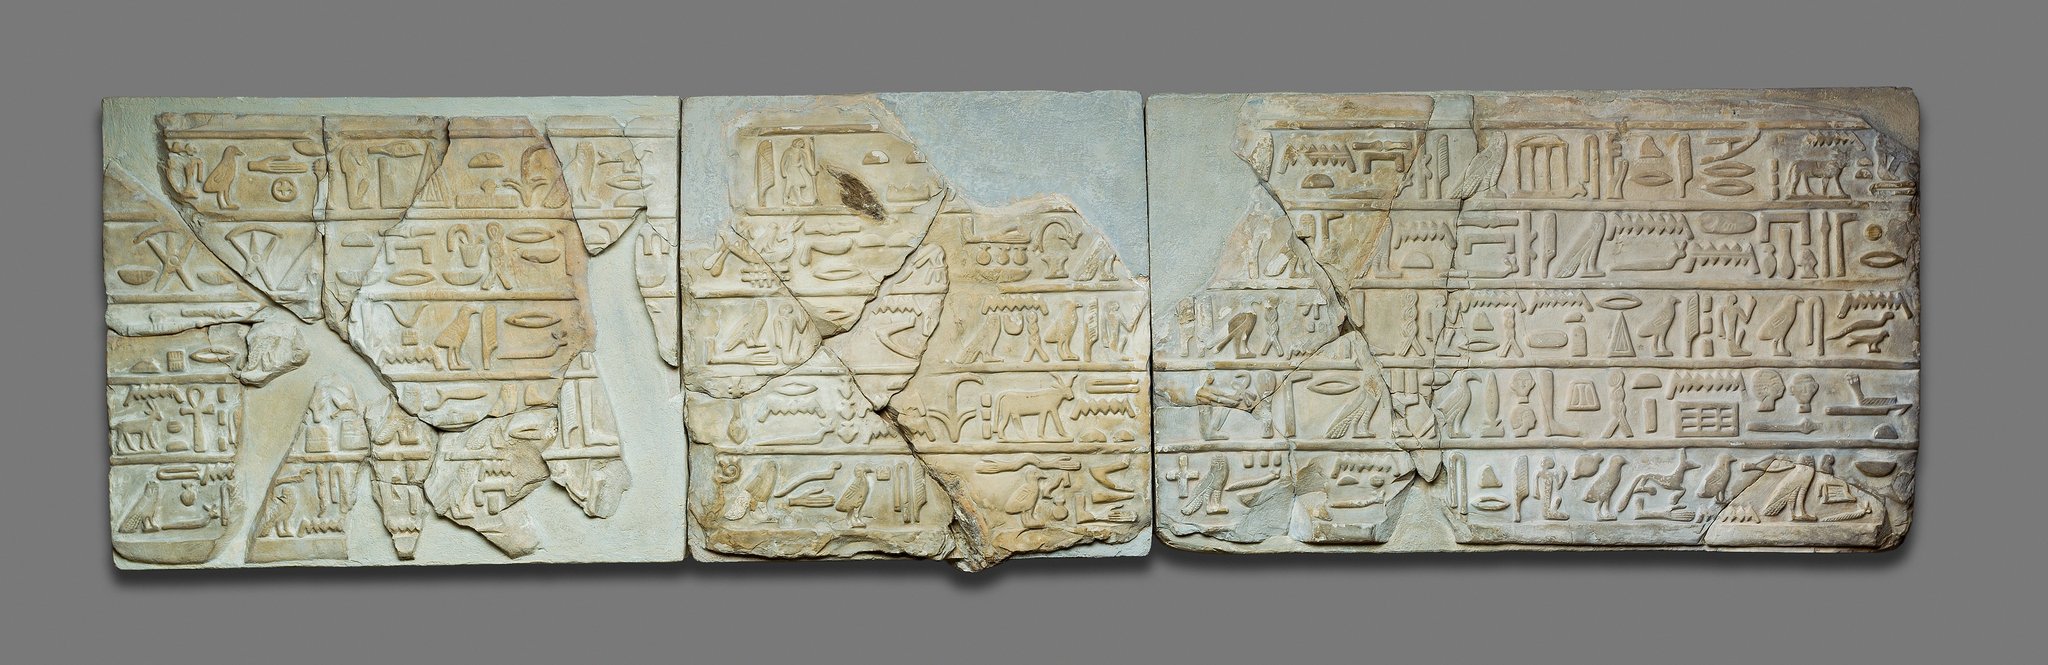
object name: relief fragment, tomb of mereri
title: Inscribed Lintel from the Tomb of the Overseer of Priests and Keeper of the Sacred Cattle Mereri, Describing His Exemplary Life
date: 2100-2030 BCE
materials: limestone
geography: egypt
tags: hieroglyphs